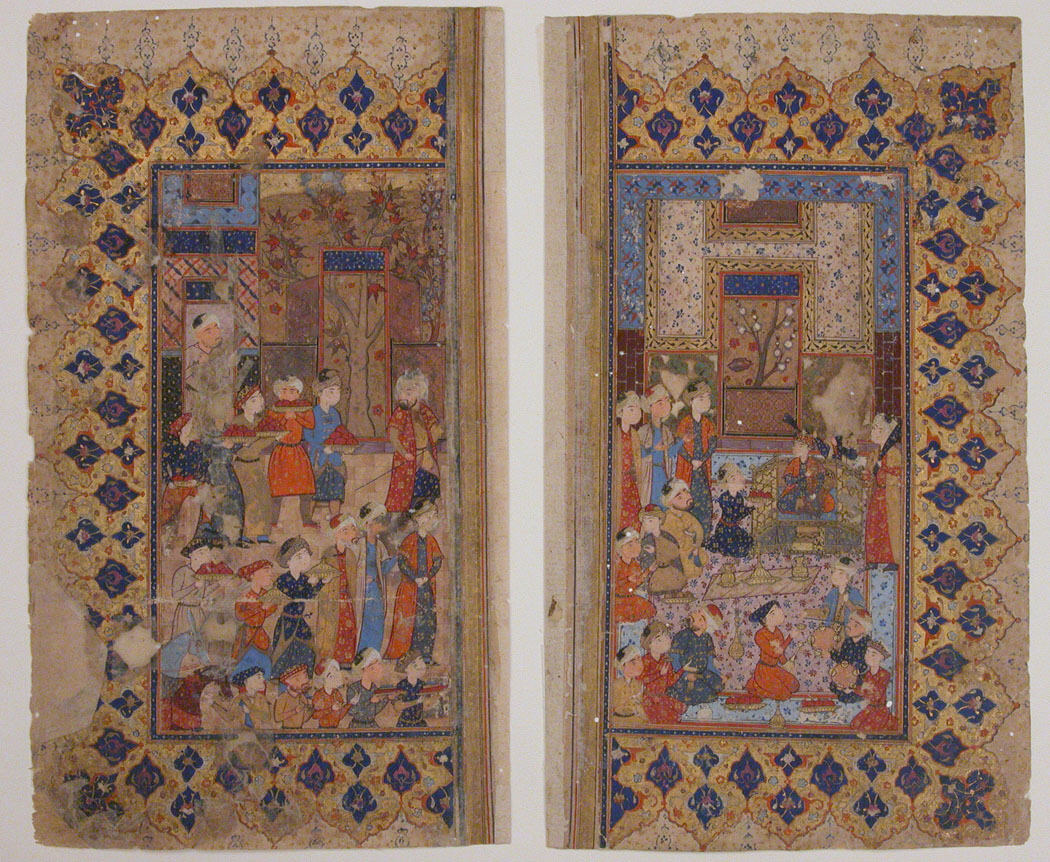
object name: folio from an illustrated manuscript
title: "Enthronement of a Young Prince (Shapur II?)", Folio from a Yusuf and Zulaikha of Jami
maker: maulana nur al-din `abd al-rahman jami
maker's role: author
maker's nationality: iranian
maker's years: 1414-1492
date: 1551-1600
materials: gold, paper, watercolor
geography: iran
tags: princes,men,ceremony